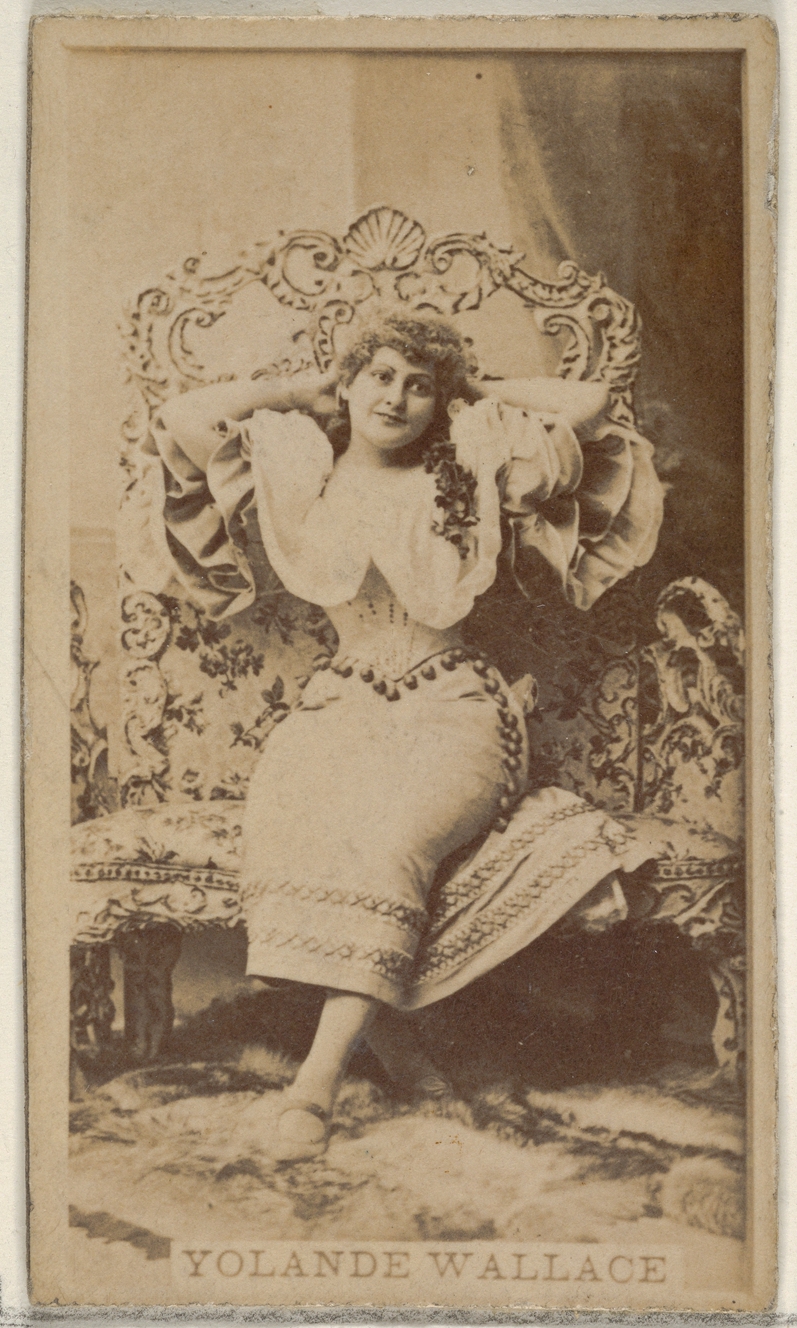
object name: photograph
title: Yolande Wallace, from the Actors and Actresses series (N45, Type 8) for Virginia Brights Cigarettes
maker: allen & ginter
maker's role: publisher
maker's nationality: american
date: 1888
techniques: albumen silver print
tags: portraits,women,actresses